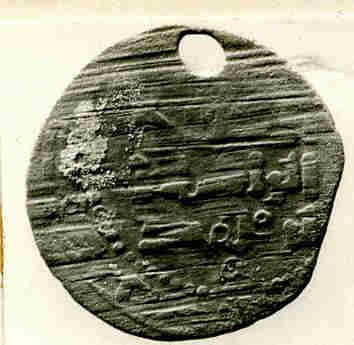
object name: coin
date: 601-1400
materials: copper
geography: iran